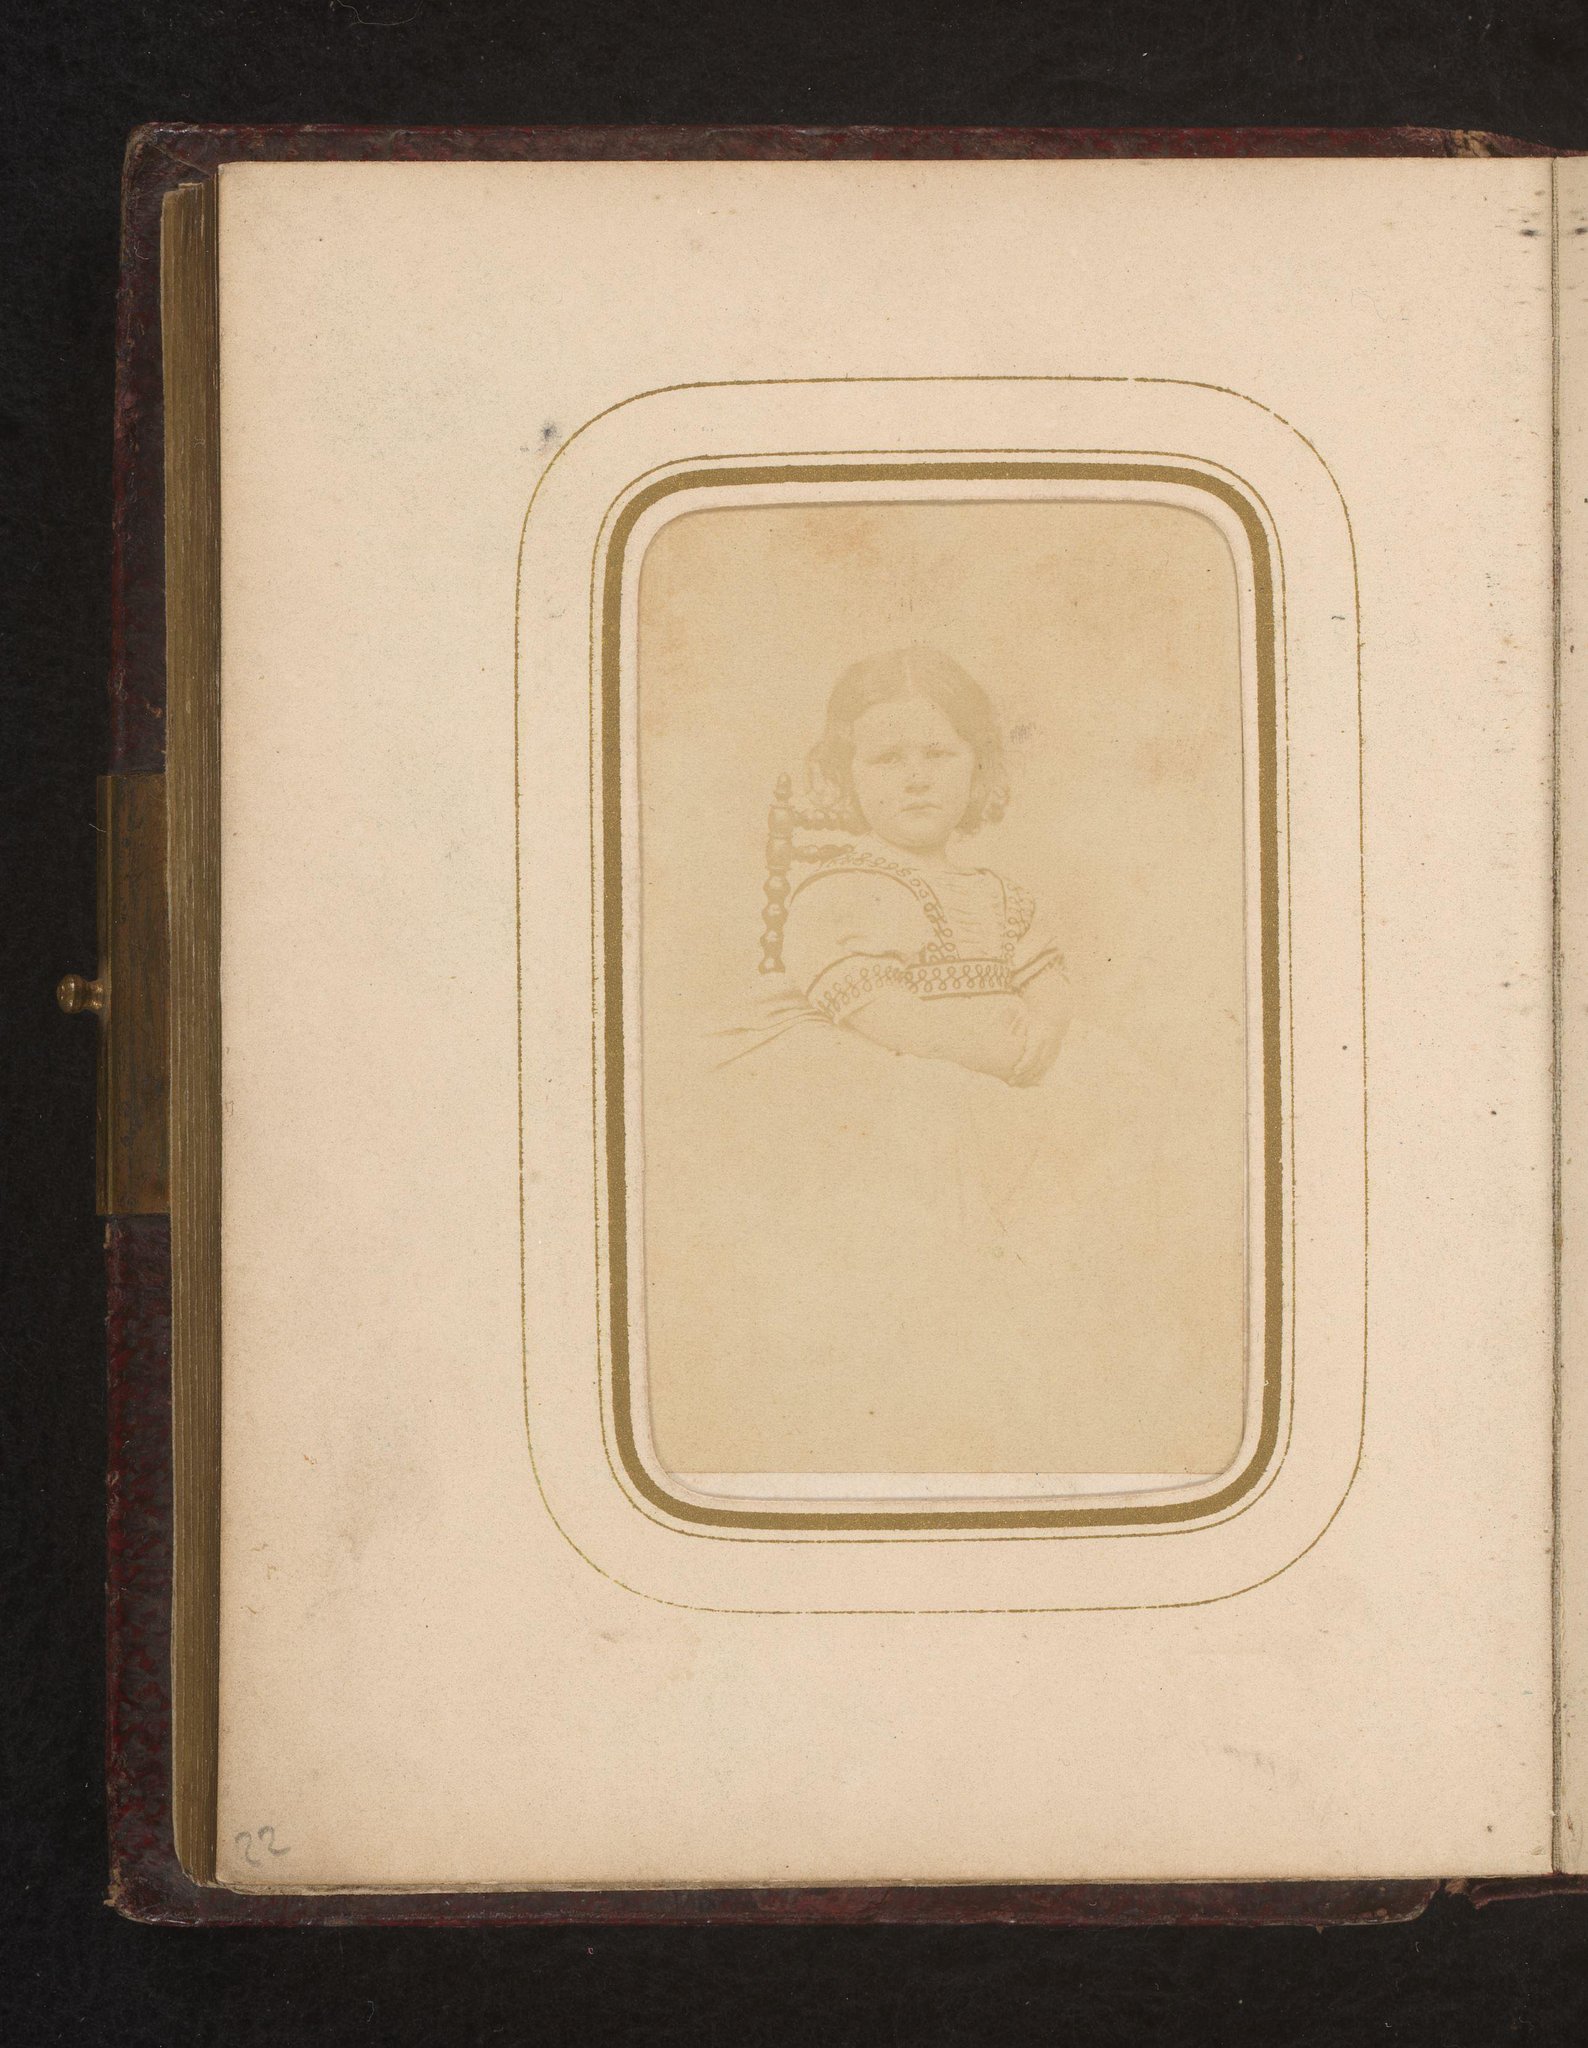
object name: album leaf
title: Portret van een meisje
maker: Anonymous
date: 1860-1890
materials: cardboard, photographic support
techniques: albumen print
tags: girl (child between toddler and youth)